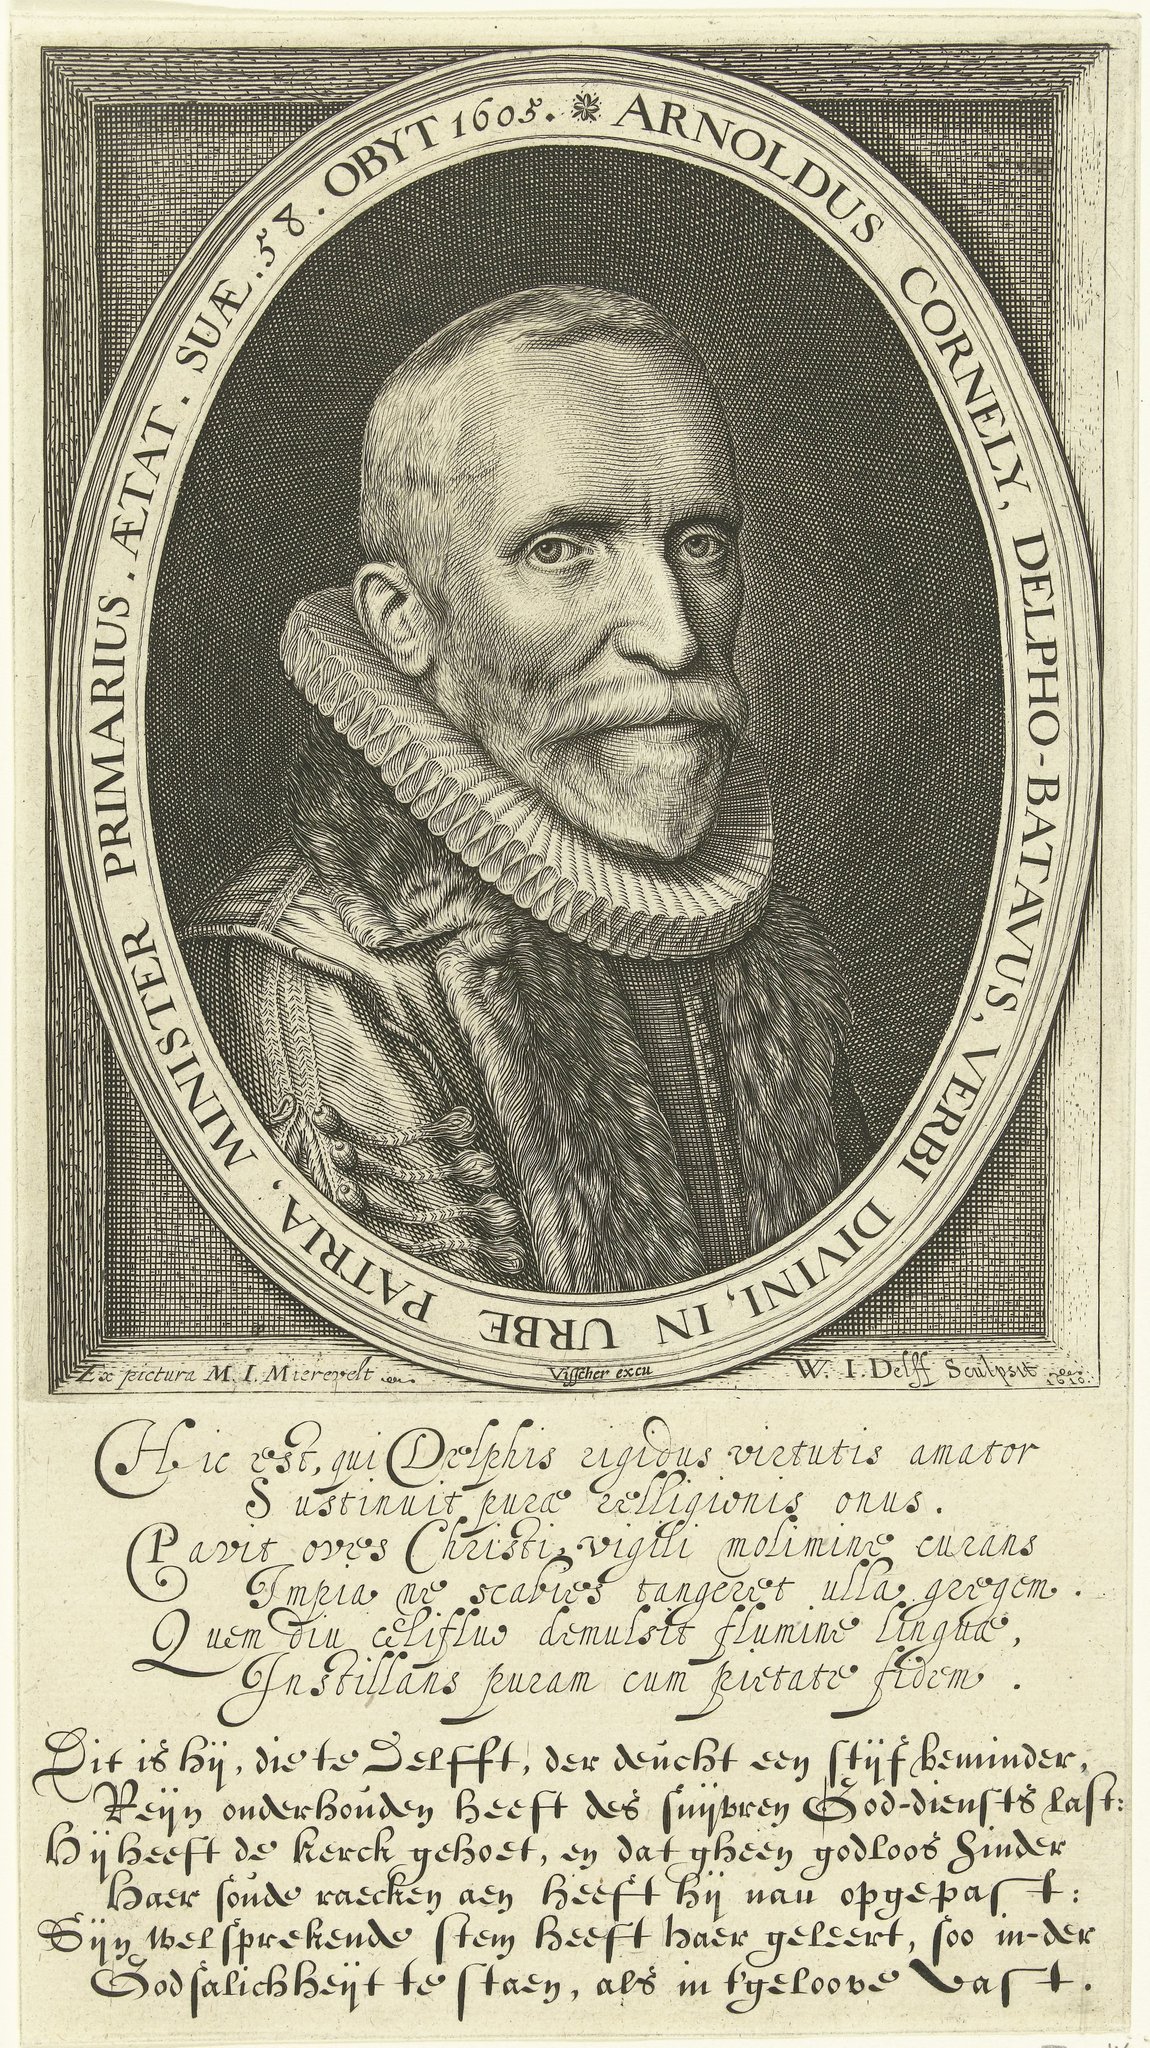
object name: print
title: Portret van predikant Arnold Cornelisz. Crusius op 58-jarige leeftijd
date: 1610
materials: paper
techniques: engraving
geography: delft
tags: delft, functionaries and dignitaries (with name) ~ episcopal protestant churches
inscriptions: collector's mark: Lugt 2228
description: Portret van predikant Arnold Cornelisz. Crusius op 58-jarige leeftijd, borststuk met molenkraag en toga in ovale omlijsting met Latijns opschrift. In ondermarge twee lofdichten, in Latijns en Nederlands, in zes regels gedrukt met een aparte plaat.